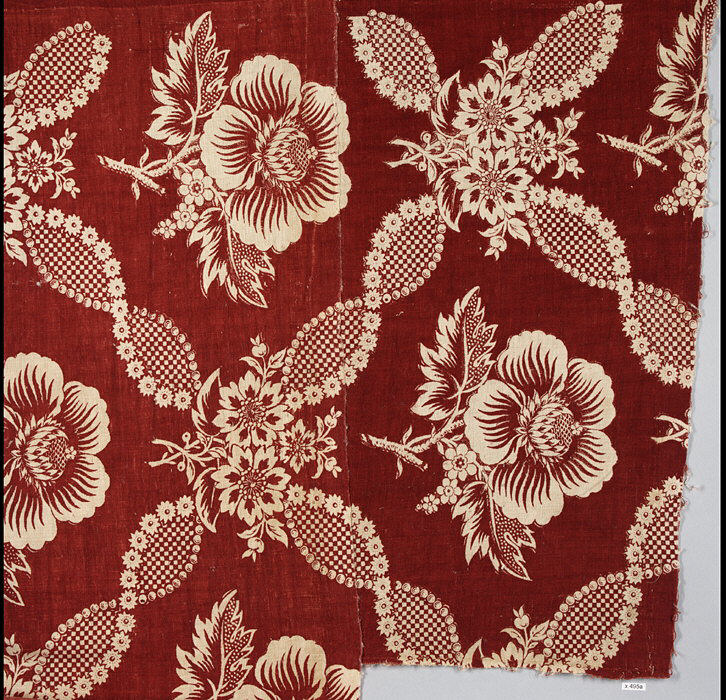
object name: piece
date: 1701-1800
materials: cotton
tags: flowers